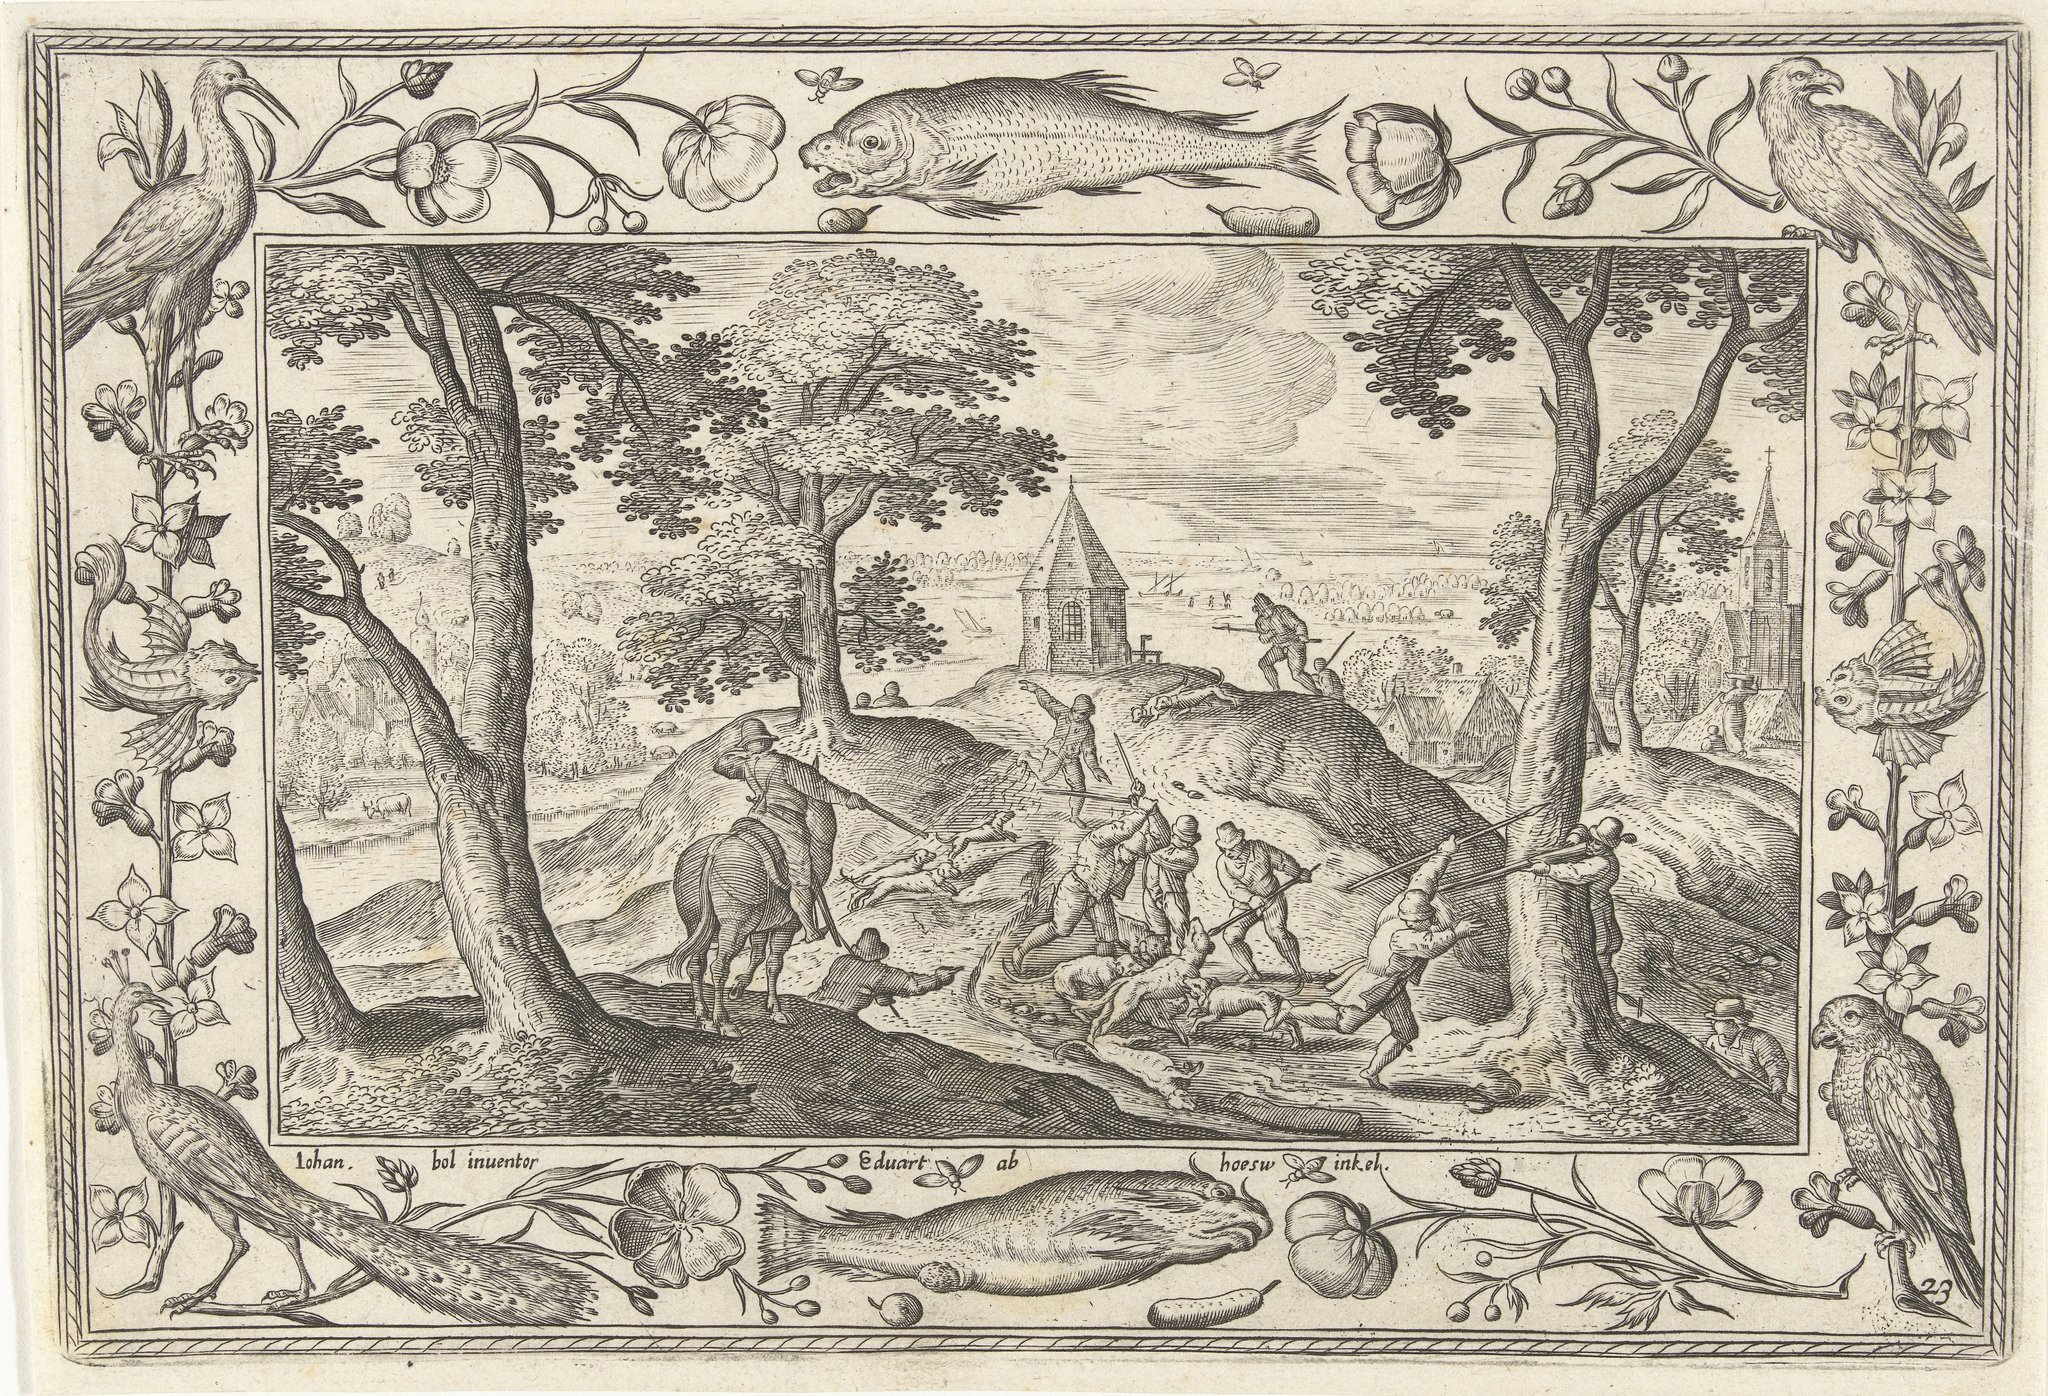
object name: print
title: Wolvenjacht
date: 1582-1586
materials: paper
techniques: engraving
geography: antwerp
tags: ornamental birds, ornamental birds: peacock, forest, wood, fishes (+ ornamental variants of animals), hunt ~ predatory animals (fox, lion) (+ hunting with dogs), flowers ~ ornament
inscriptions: collector's mark: Lugt 2228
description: Boslandschap met wolvenjacht. Op de voorgrond wordt een wolf gedood door enkele jagers en hun honden. De prent heeft een ornamentele lijst met bloemen, vissen en dieren. Hij maakt deel uit van een vierentwintigdelige serie van landschappen met Bijbelse, mythologische scènes en jachttaferelen.